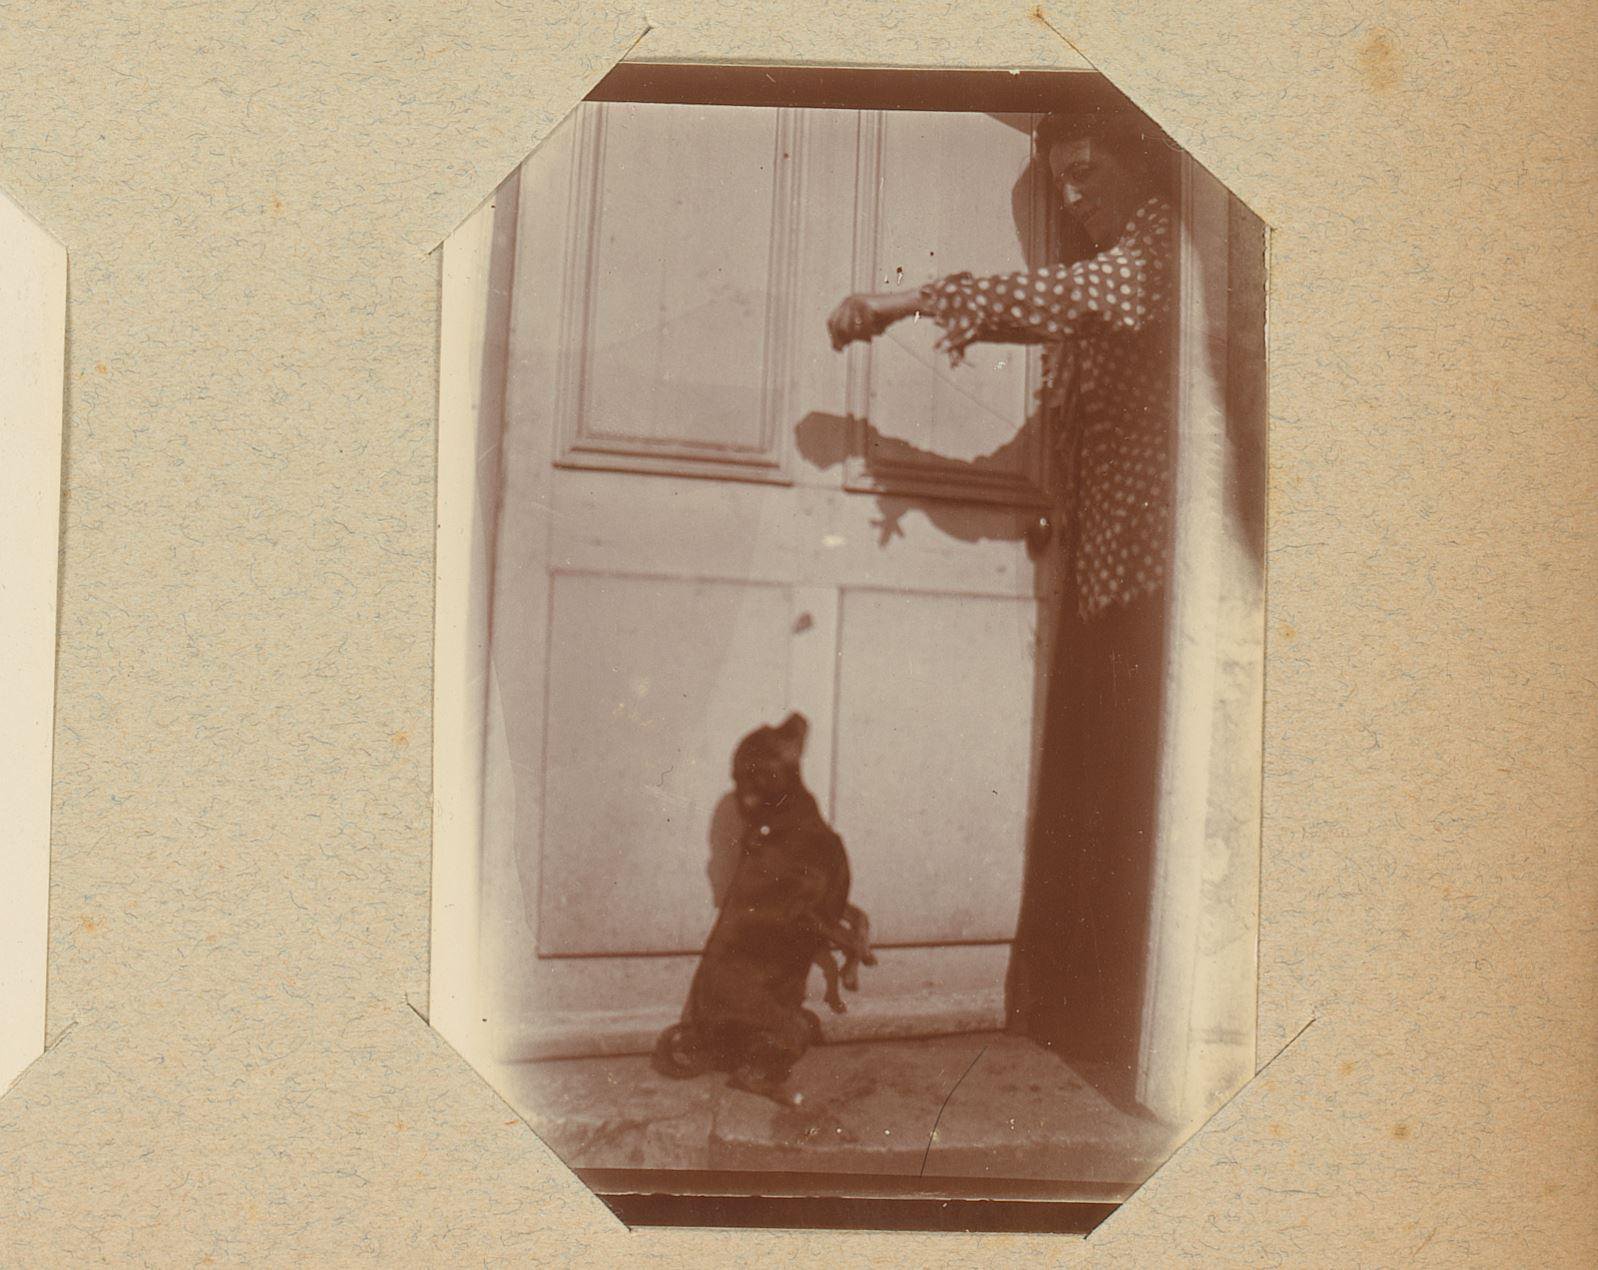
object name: photograph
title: Vrouw in deuropening met een hond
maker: Anonymous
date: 1897-1900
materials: paper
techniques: gelatin silver print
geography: france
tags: adult woman, dog, france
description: Over de foto is een ander negatief afgedrukt van een voorstelling van bomen.